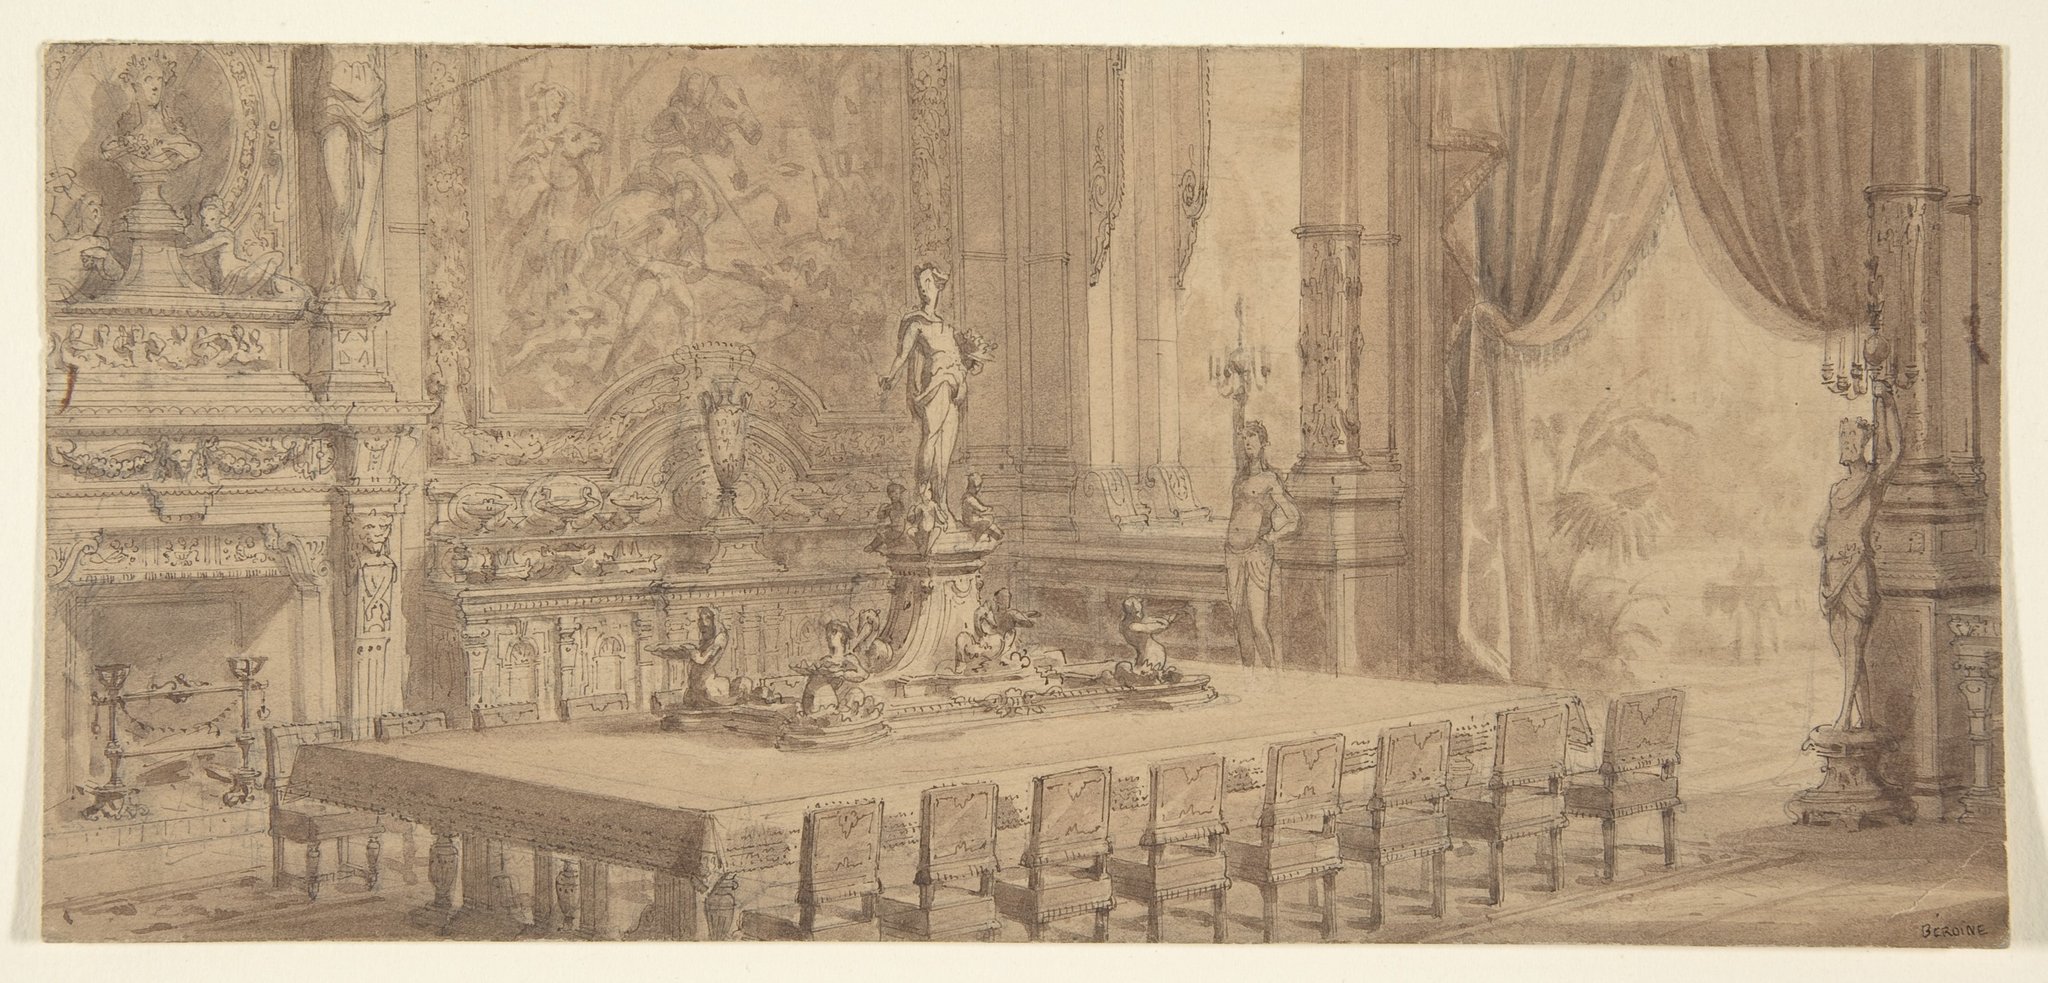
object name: drawing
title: Architectural Interior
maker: anonymous, french, 19th century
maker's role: artist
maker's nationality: french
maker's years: 1800-1900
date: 1801-1900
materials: graphite, ink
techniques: brush, pen, wash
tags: interiors,chairs,tables